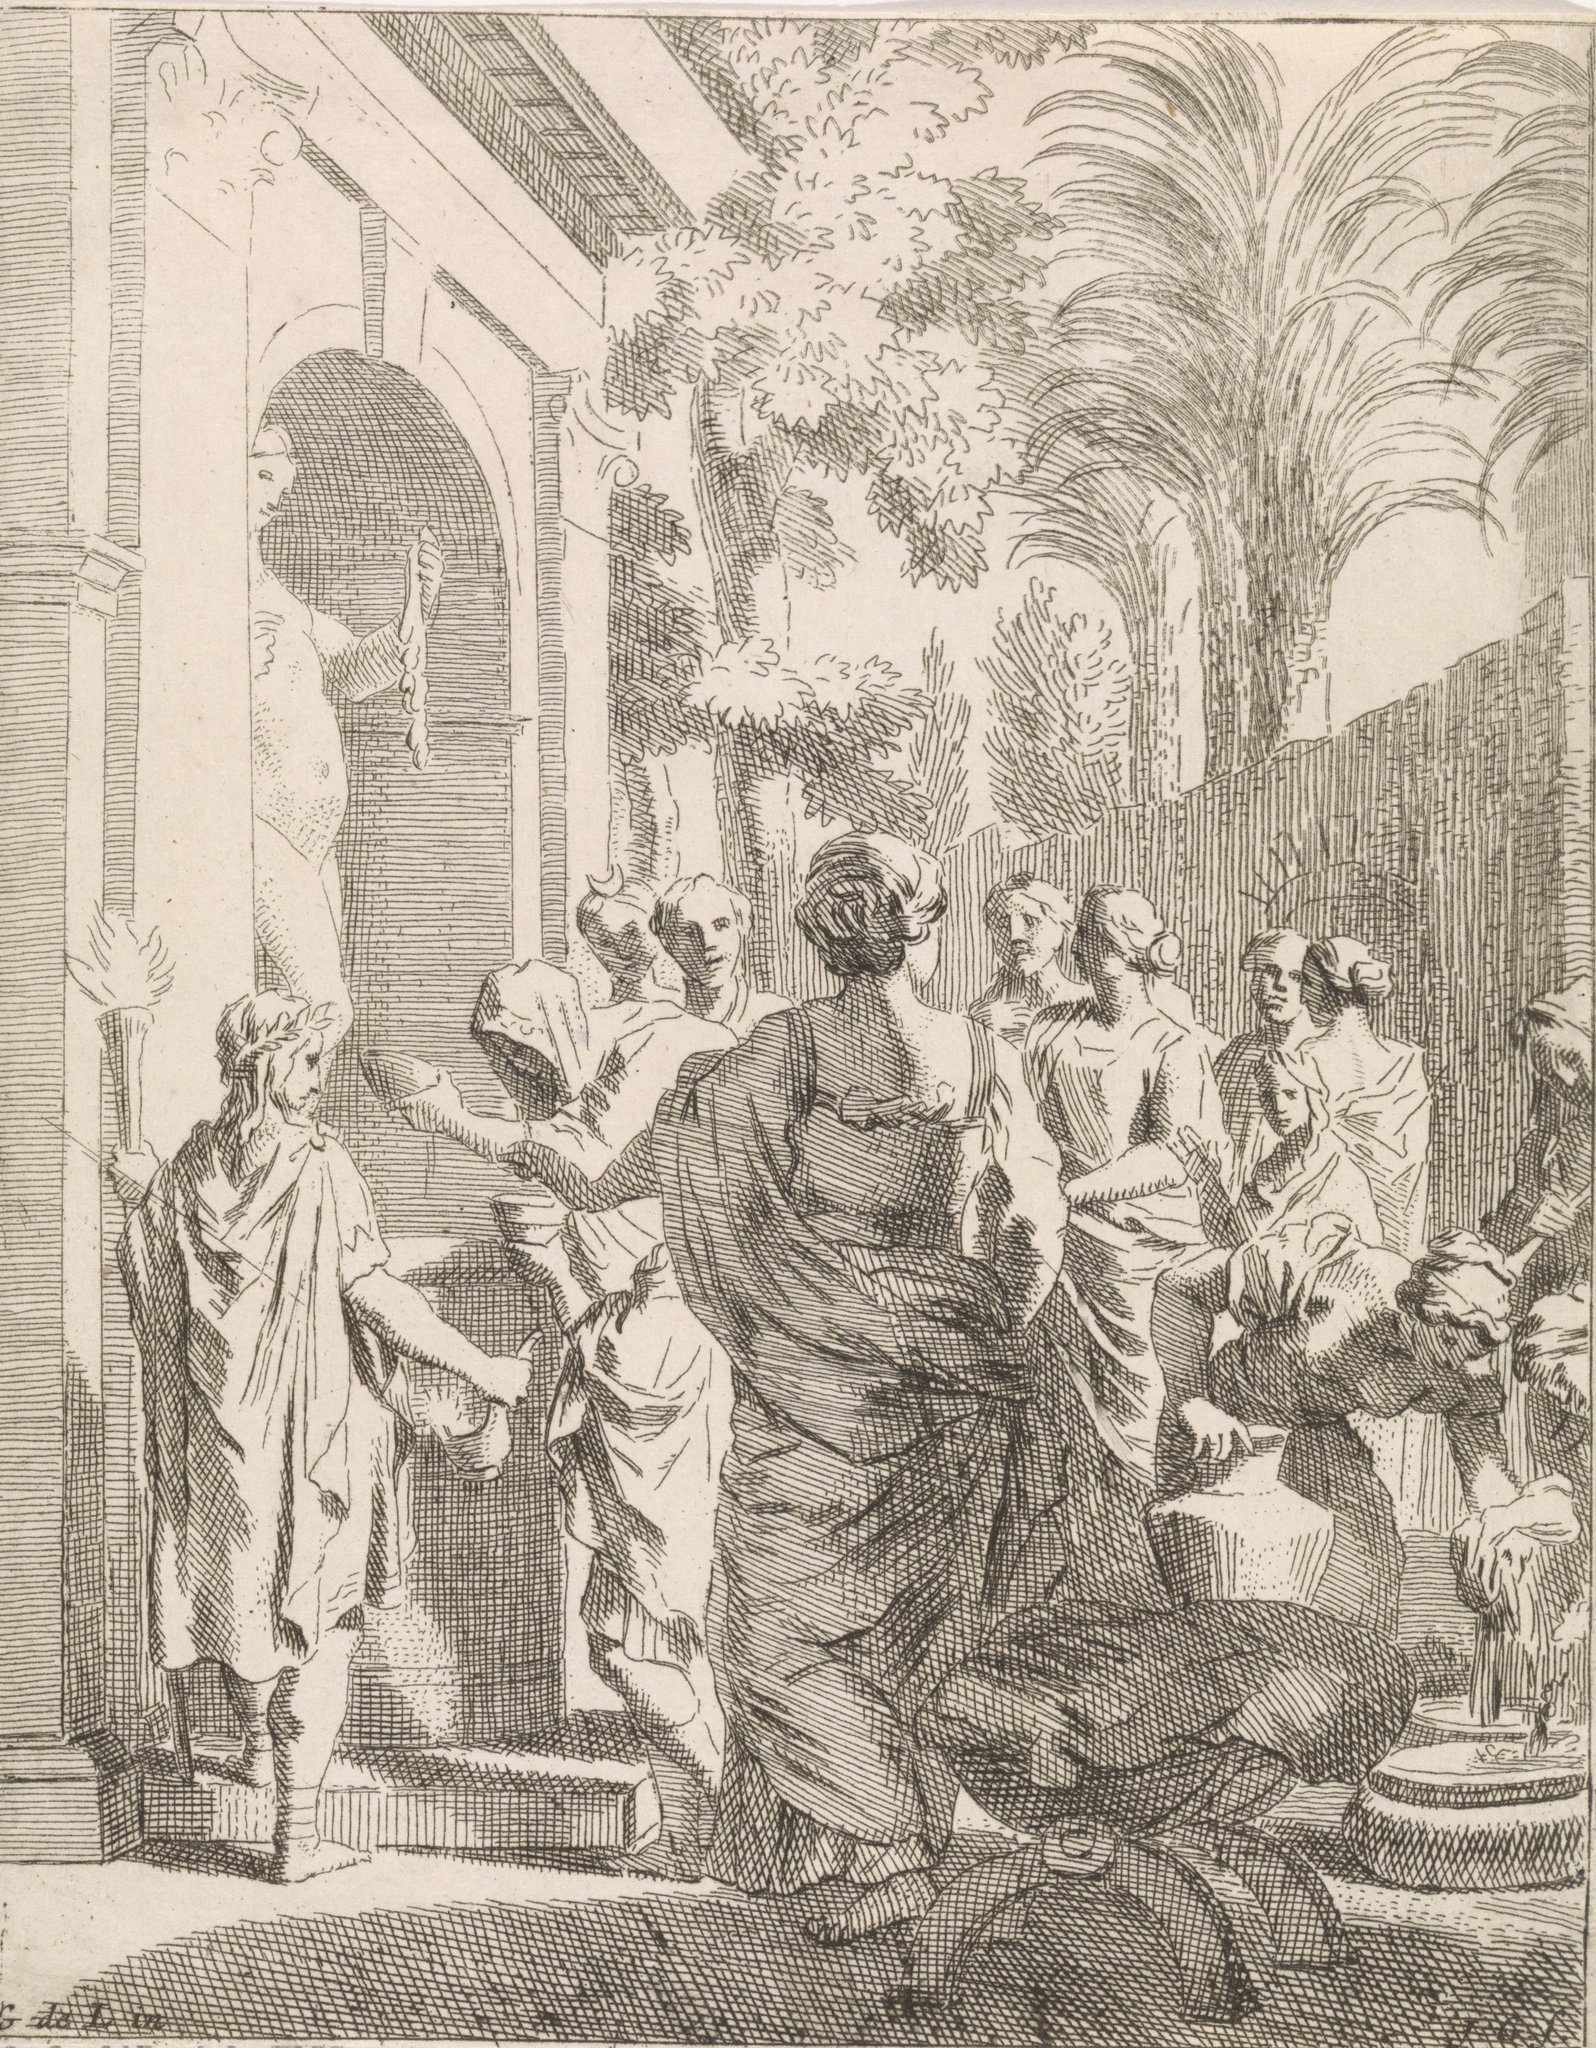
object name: print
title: Offer aan Venus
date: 1656-1726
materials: paper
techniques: etching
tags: statues, paintings, etc. ~ objects of worship in roman religion, (story of) venus (aphrodite), sacrifice ~ roman religion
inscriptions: collector's mark: Lugt 240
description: Een religieuze ceremonie bij een standbeeld van Venus. Enkele Romeinse burgers offeren aan de godin. De prent maakt deel uit van een serie met mythologische en allegorische voorstellingen.